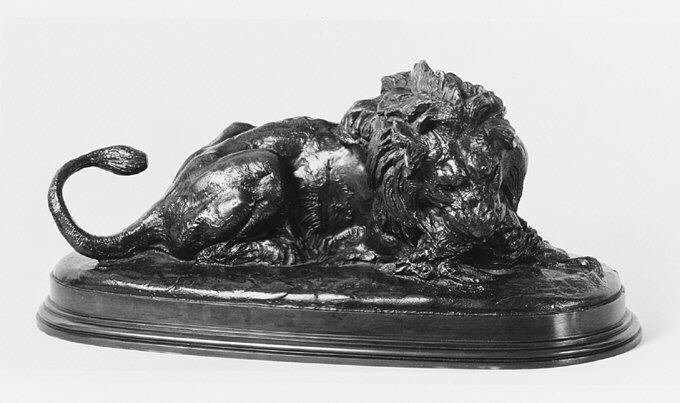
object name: statuette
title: Lion Devouring a Doe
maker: antoine-louis barye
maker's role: artist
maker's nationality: french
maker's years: 1795-1875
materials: bronze, patina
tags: lions